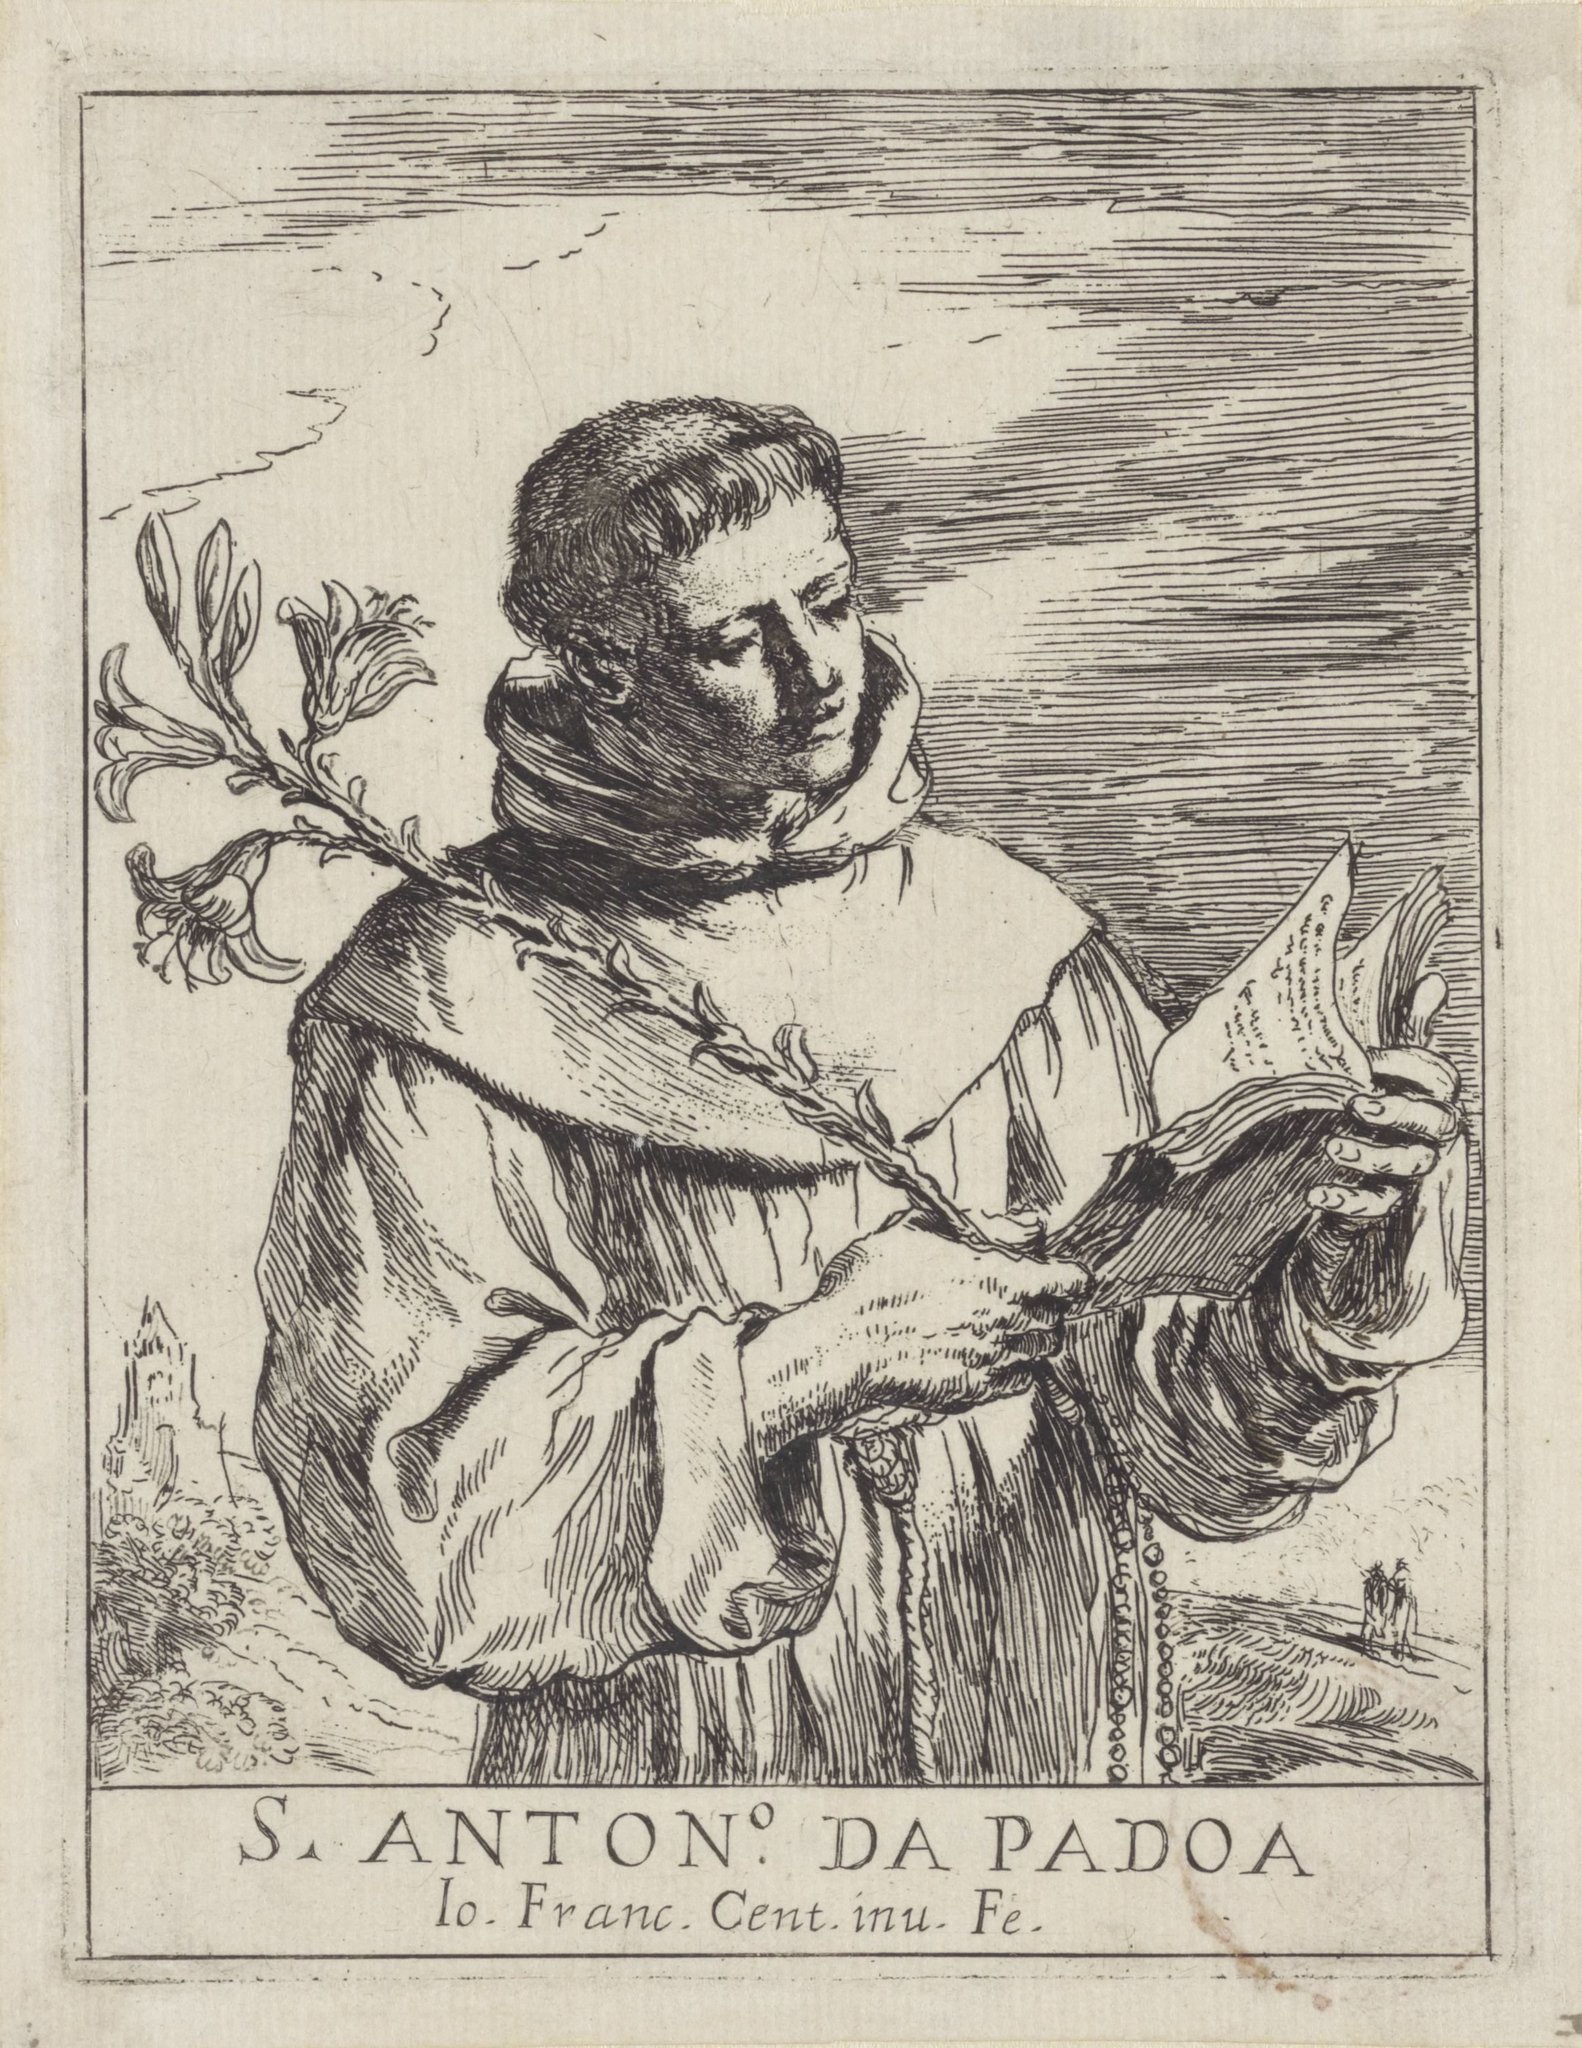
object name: print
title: De heilige Antonius van Padua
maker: g.jo.franc da cento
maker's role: draughtsman, painter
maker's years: 1591-1666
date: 1601-1666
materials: paper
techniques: etching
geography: italy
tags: the franciscan monk antony of padua; possible attributes: ass, book, crucifix, flowered cross, flaming heart, infant christ (on book), lily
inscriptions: collector's mark: Lugt 240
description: De heilige Antonius van Padua met een boek en een lelietak in zijn handen.